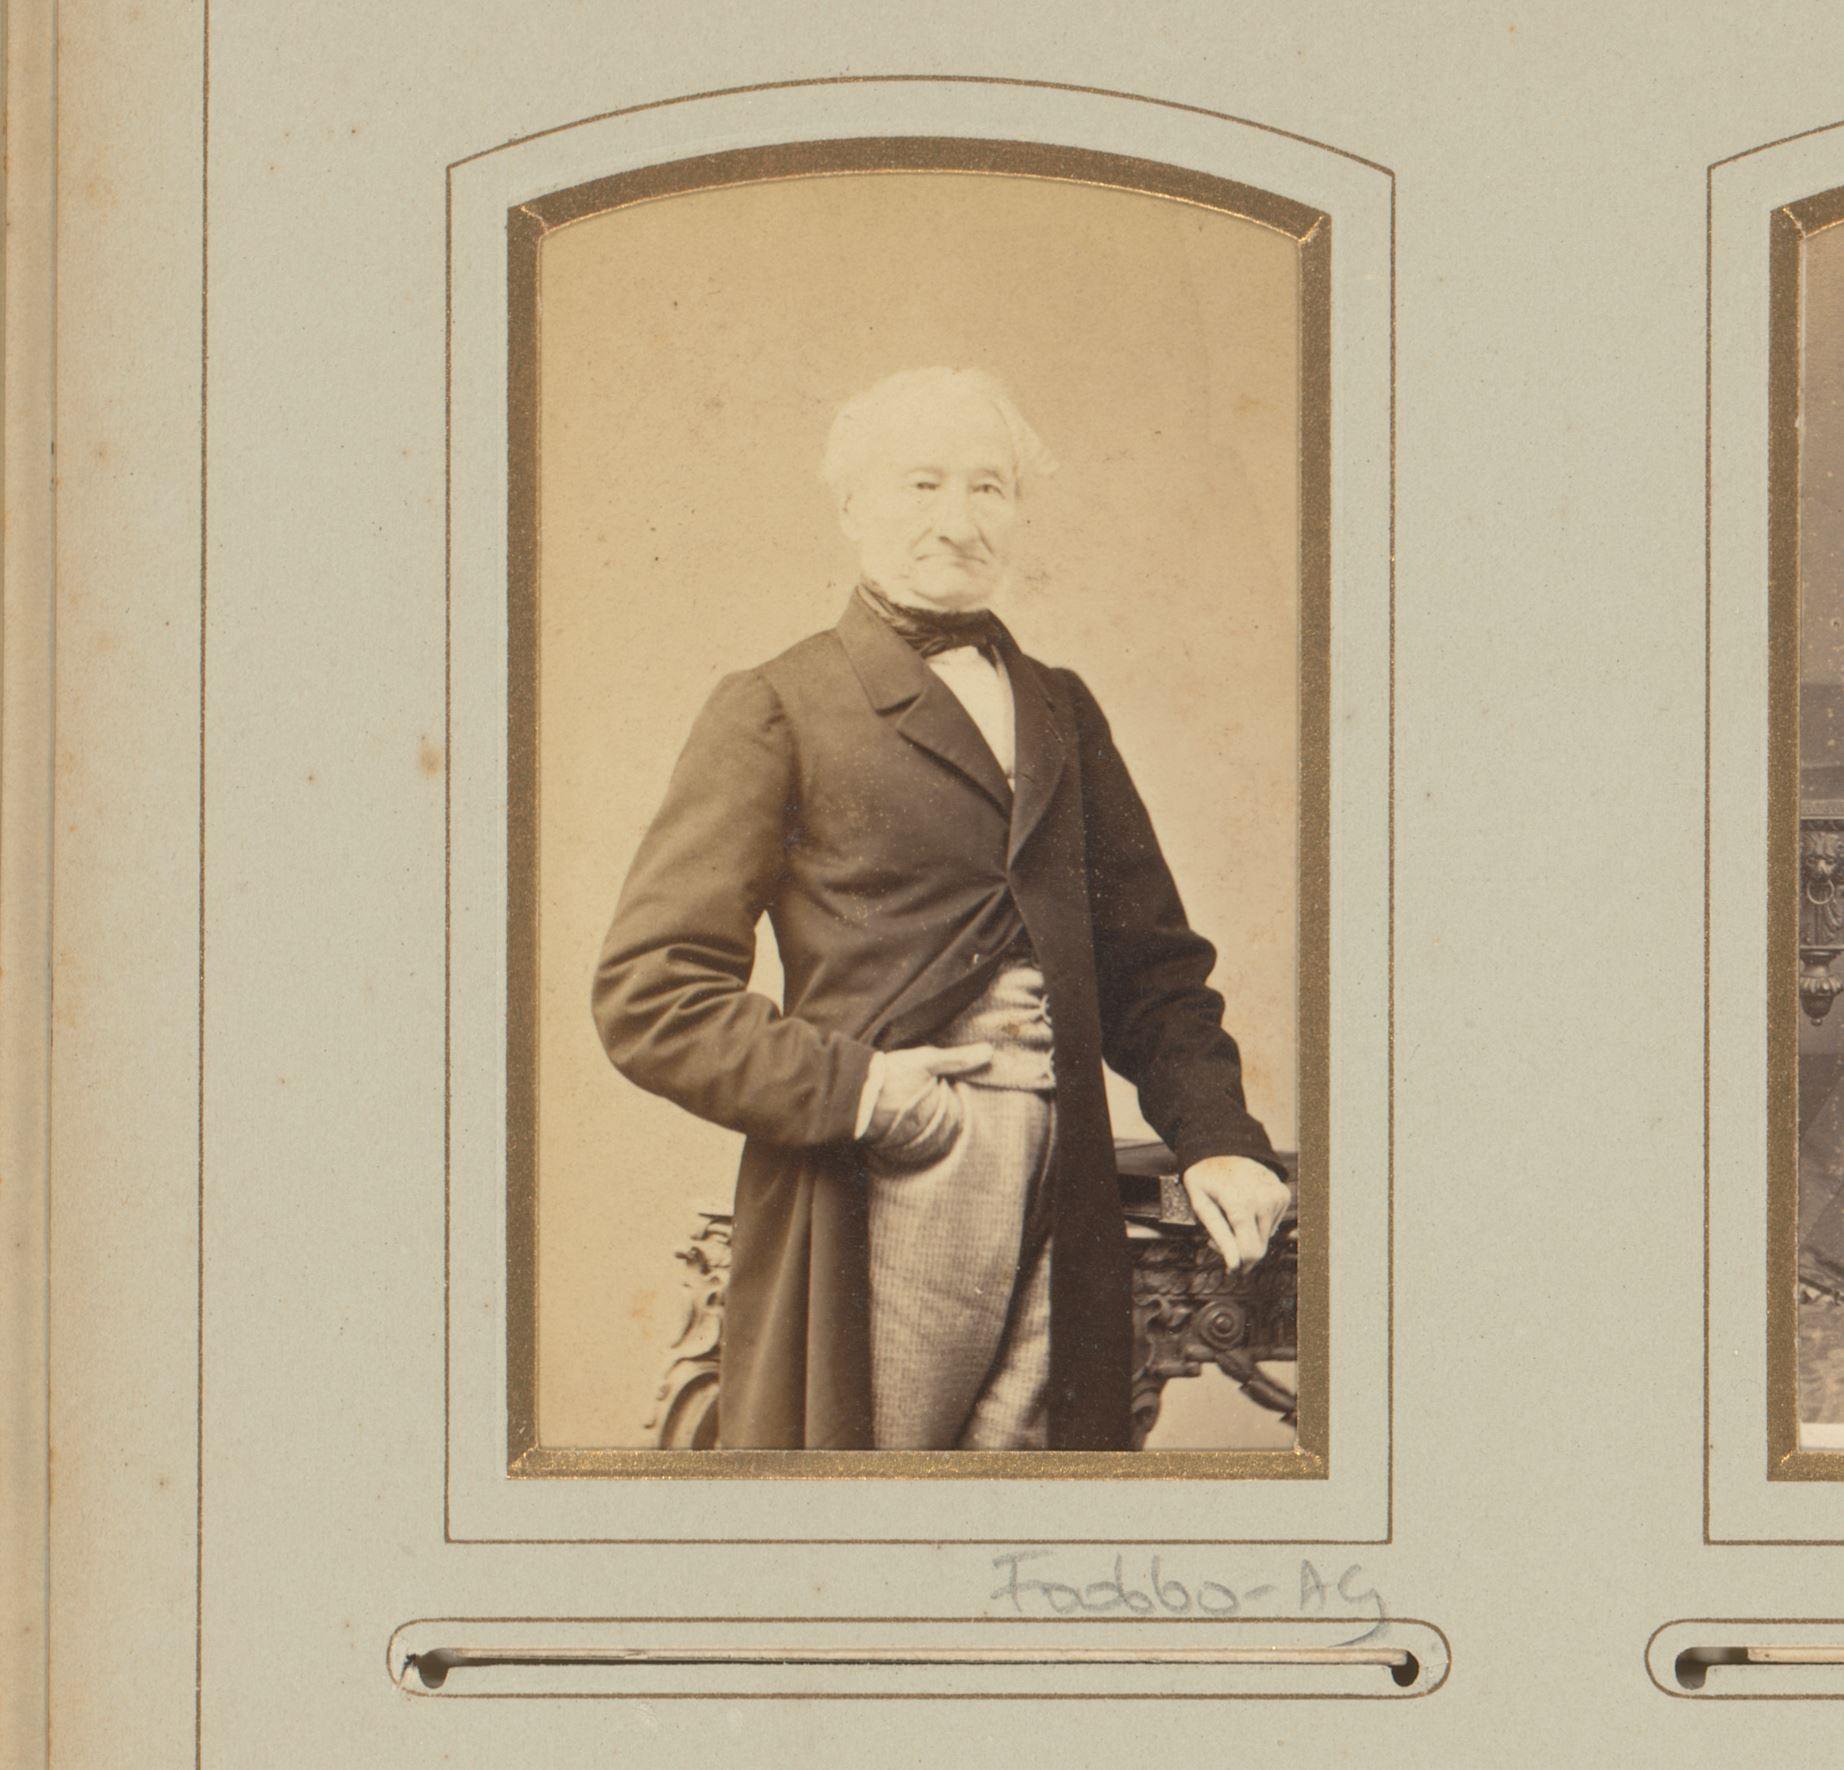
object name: carte de visite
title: Portret van een staande man met een hand in zijn broekzak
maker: jules géruzet (fotograaf)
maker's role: fotograaf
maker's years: 1817-1874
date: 1859-1874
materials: cardboard, photographic support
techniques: albumen print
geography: brussels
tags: hand in the pocket, historical persons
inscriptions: inscription: ‘JULES GÉRUZET,/ PHOTOGRAPHE,/ 27bis Rue de l'Ecuyer,/ BRUXELLES.’